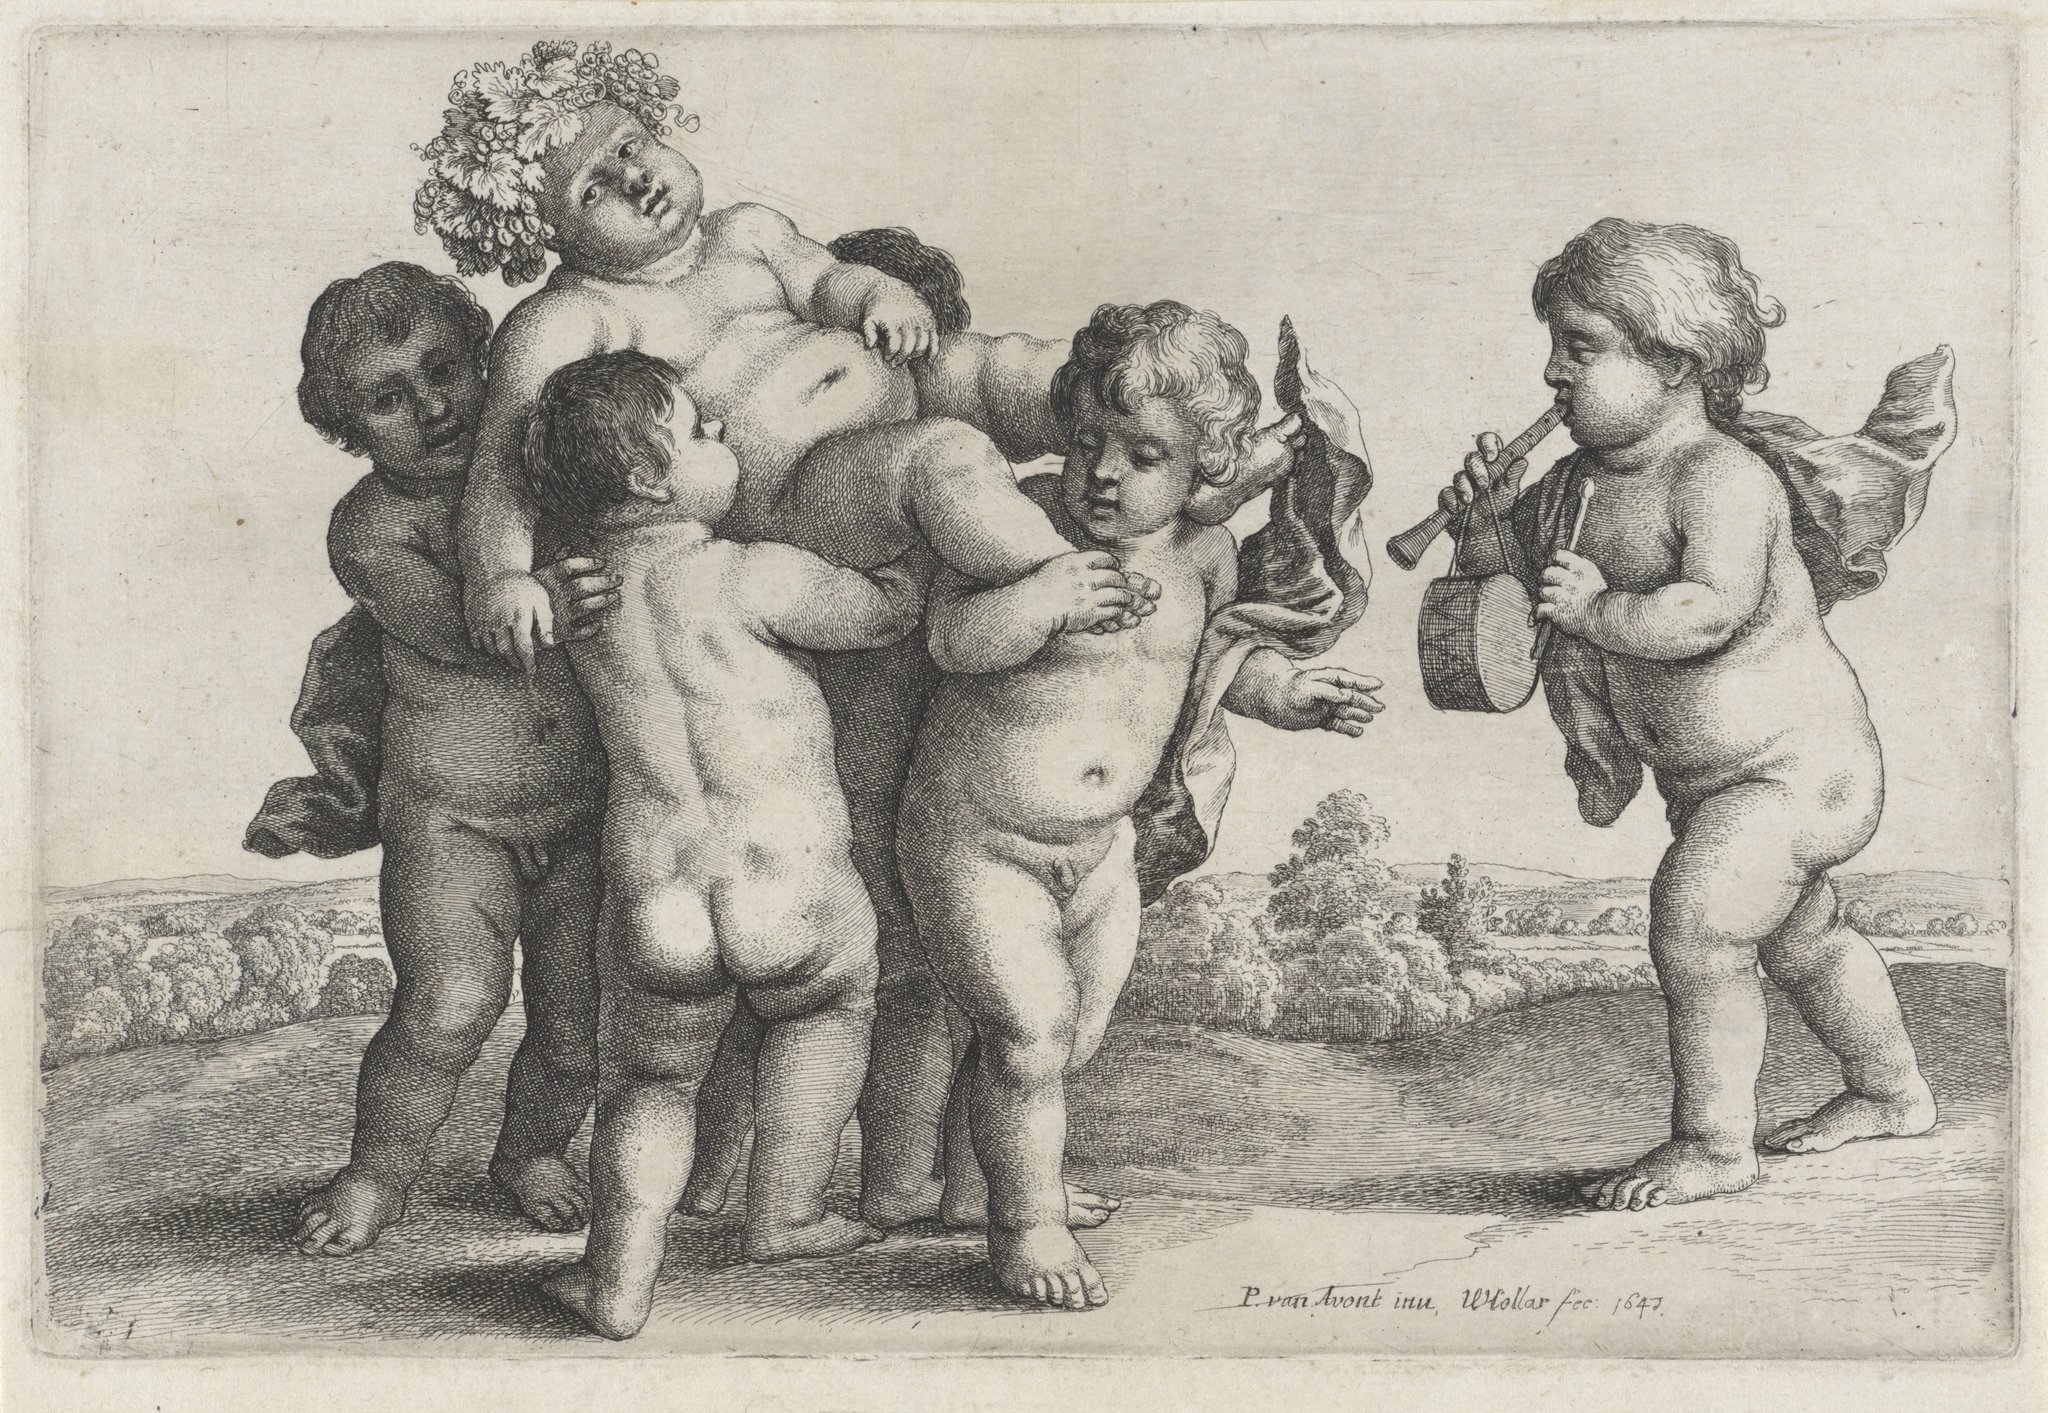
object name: print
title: Vijf jongetjes dragen een met wijnranken gekroonde jongeling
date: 1647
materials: paper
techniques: etching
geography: antwerp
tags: boy (child between toddler and youth), male bacchant(es), making music; musician with instrument - cc - out of doors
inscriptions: collector's mark: Lugt 240